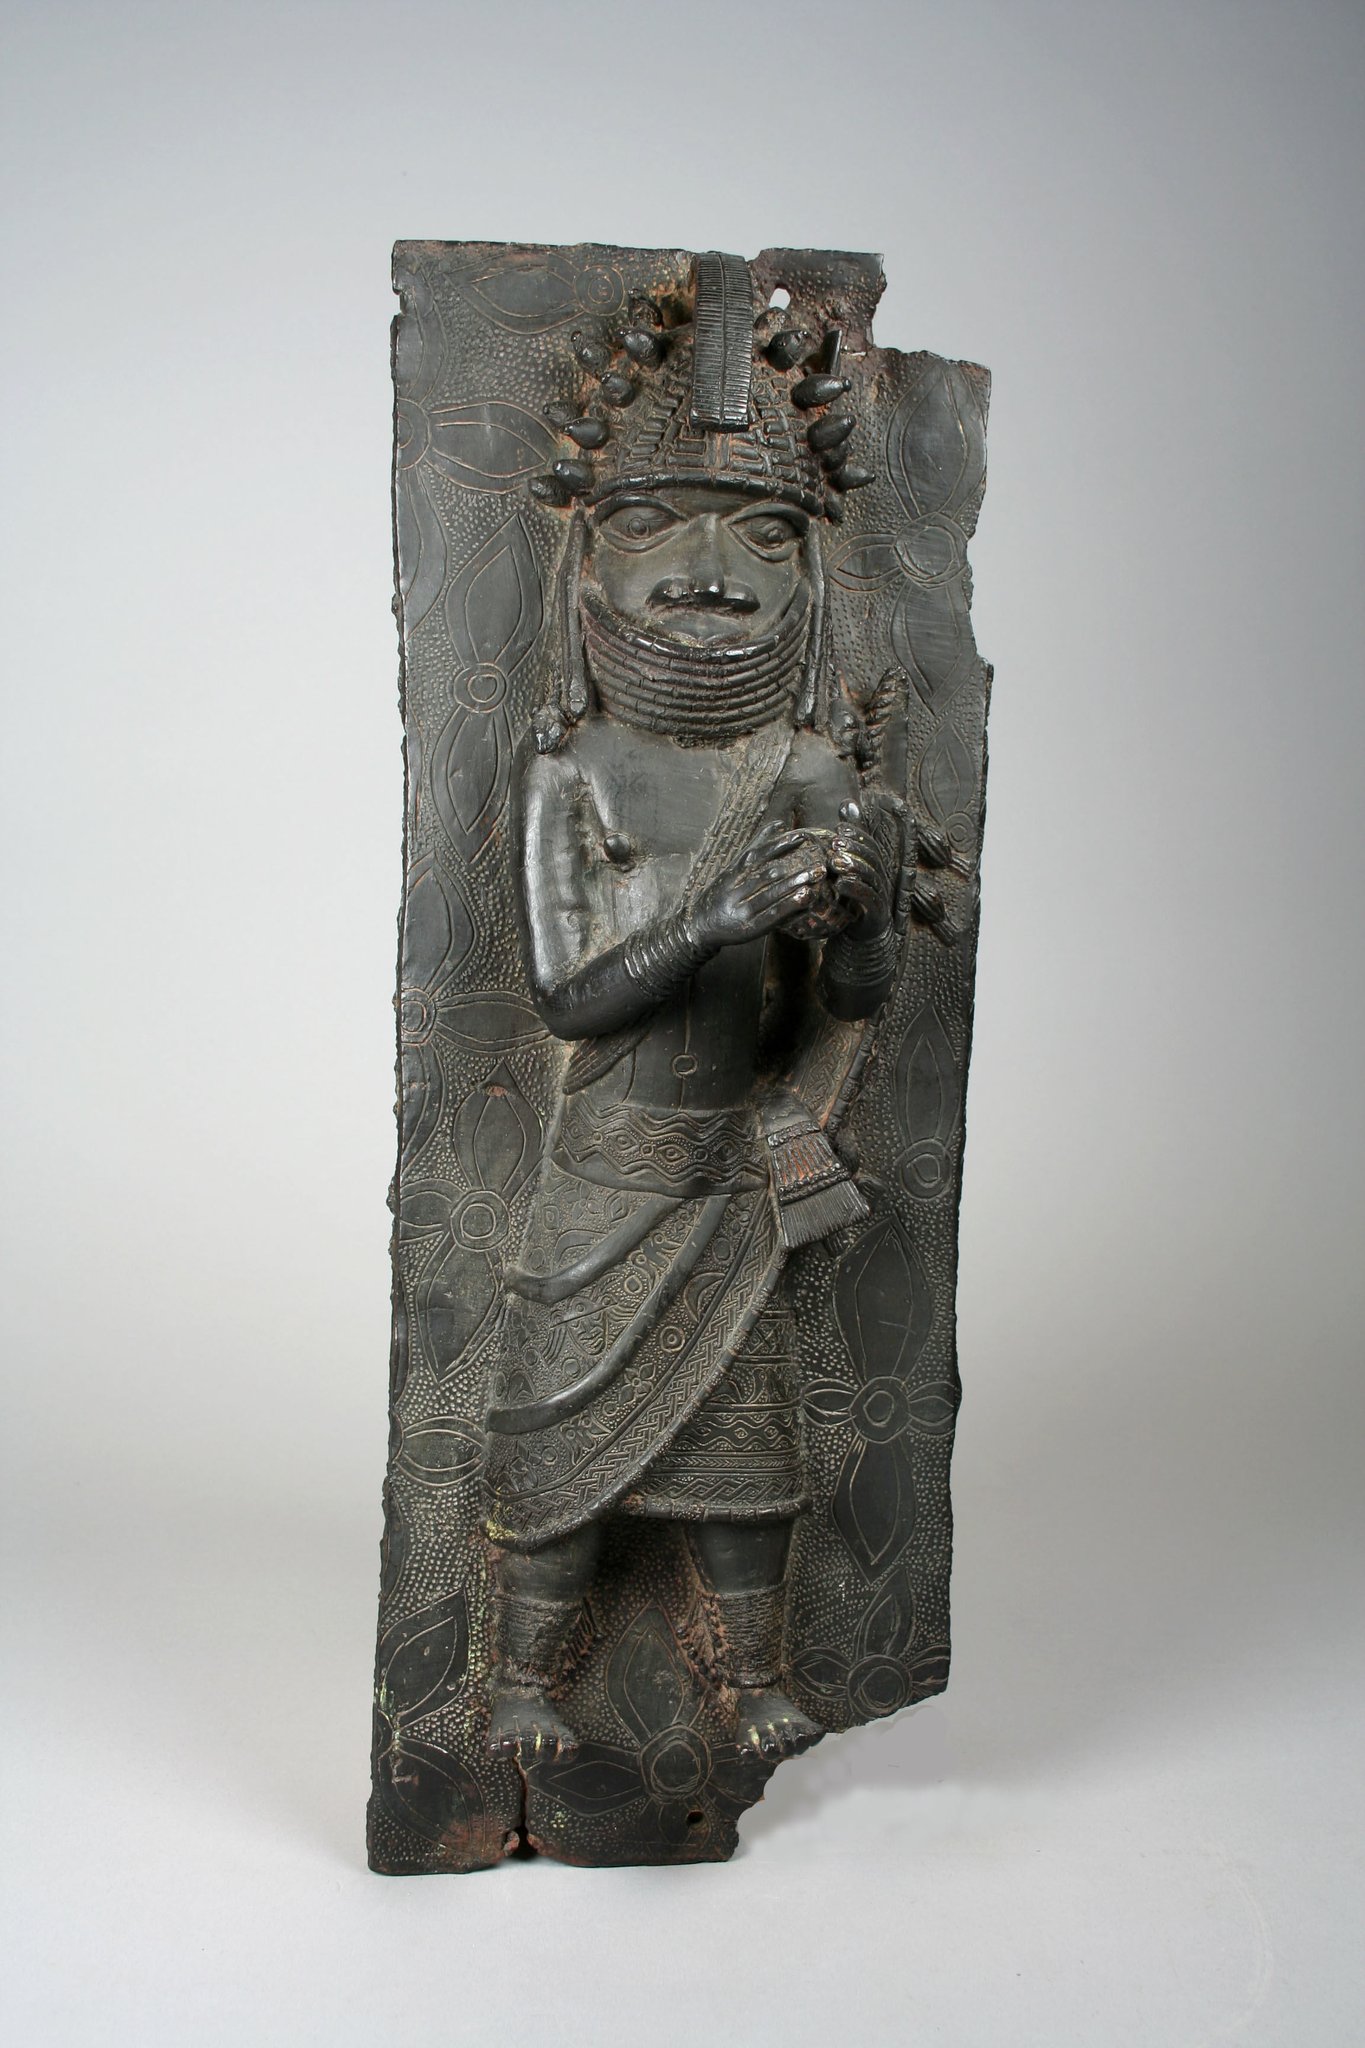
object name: plaque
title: Plaque: Titleholder with Calabash Rattle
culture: edo period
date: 1501-1700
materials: brass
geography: nigeria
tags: men